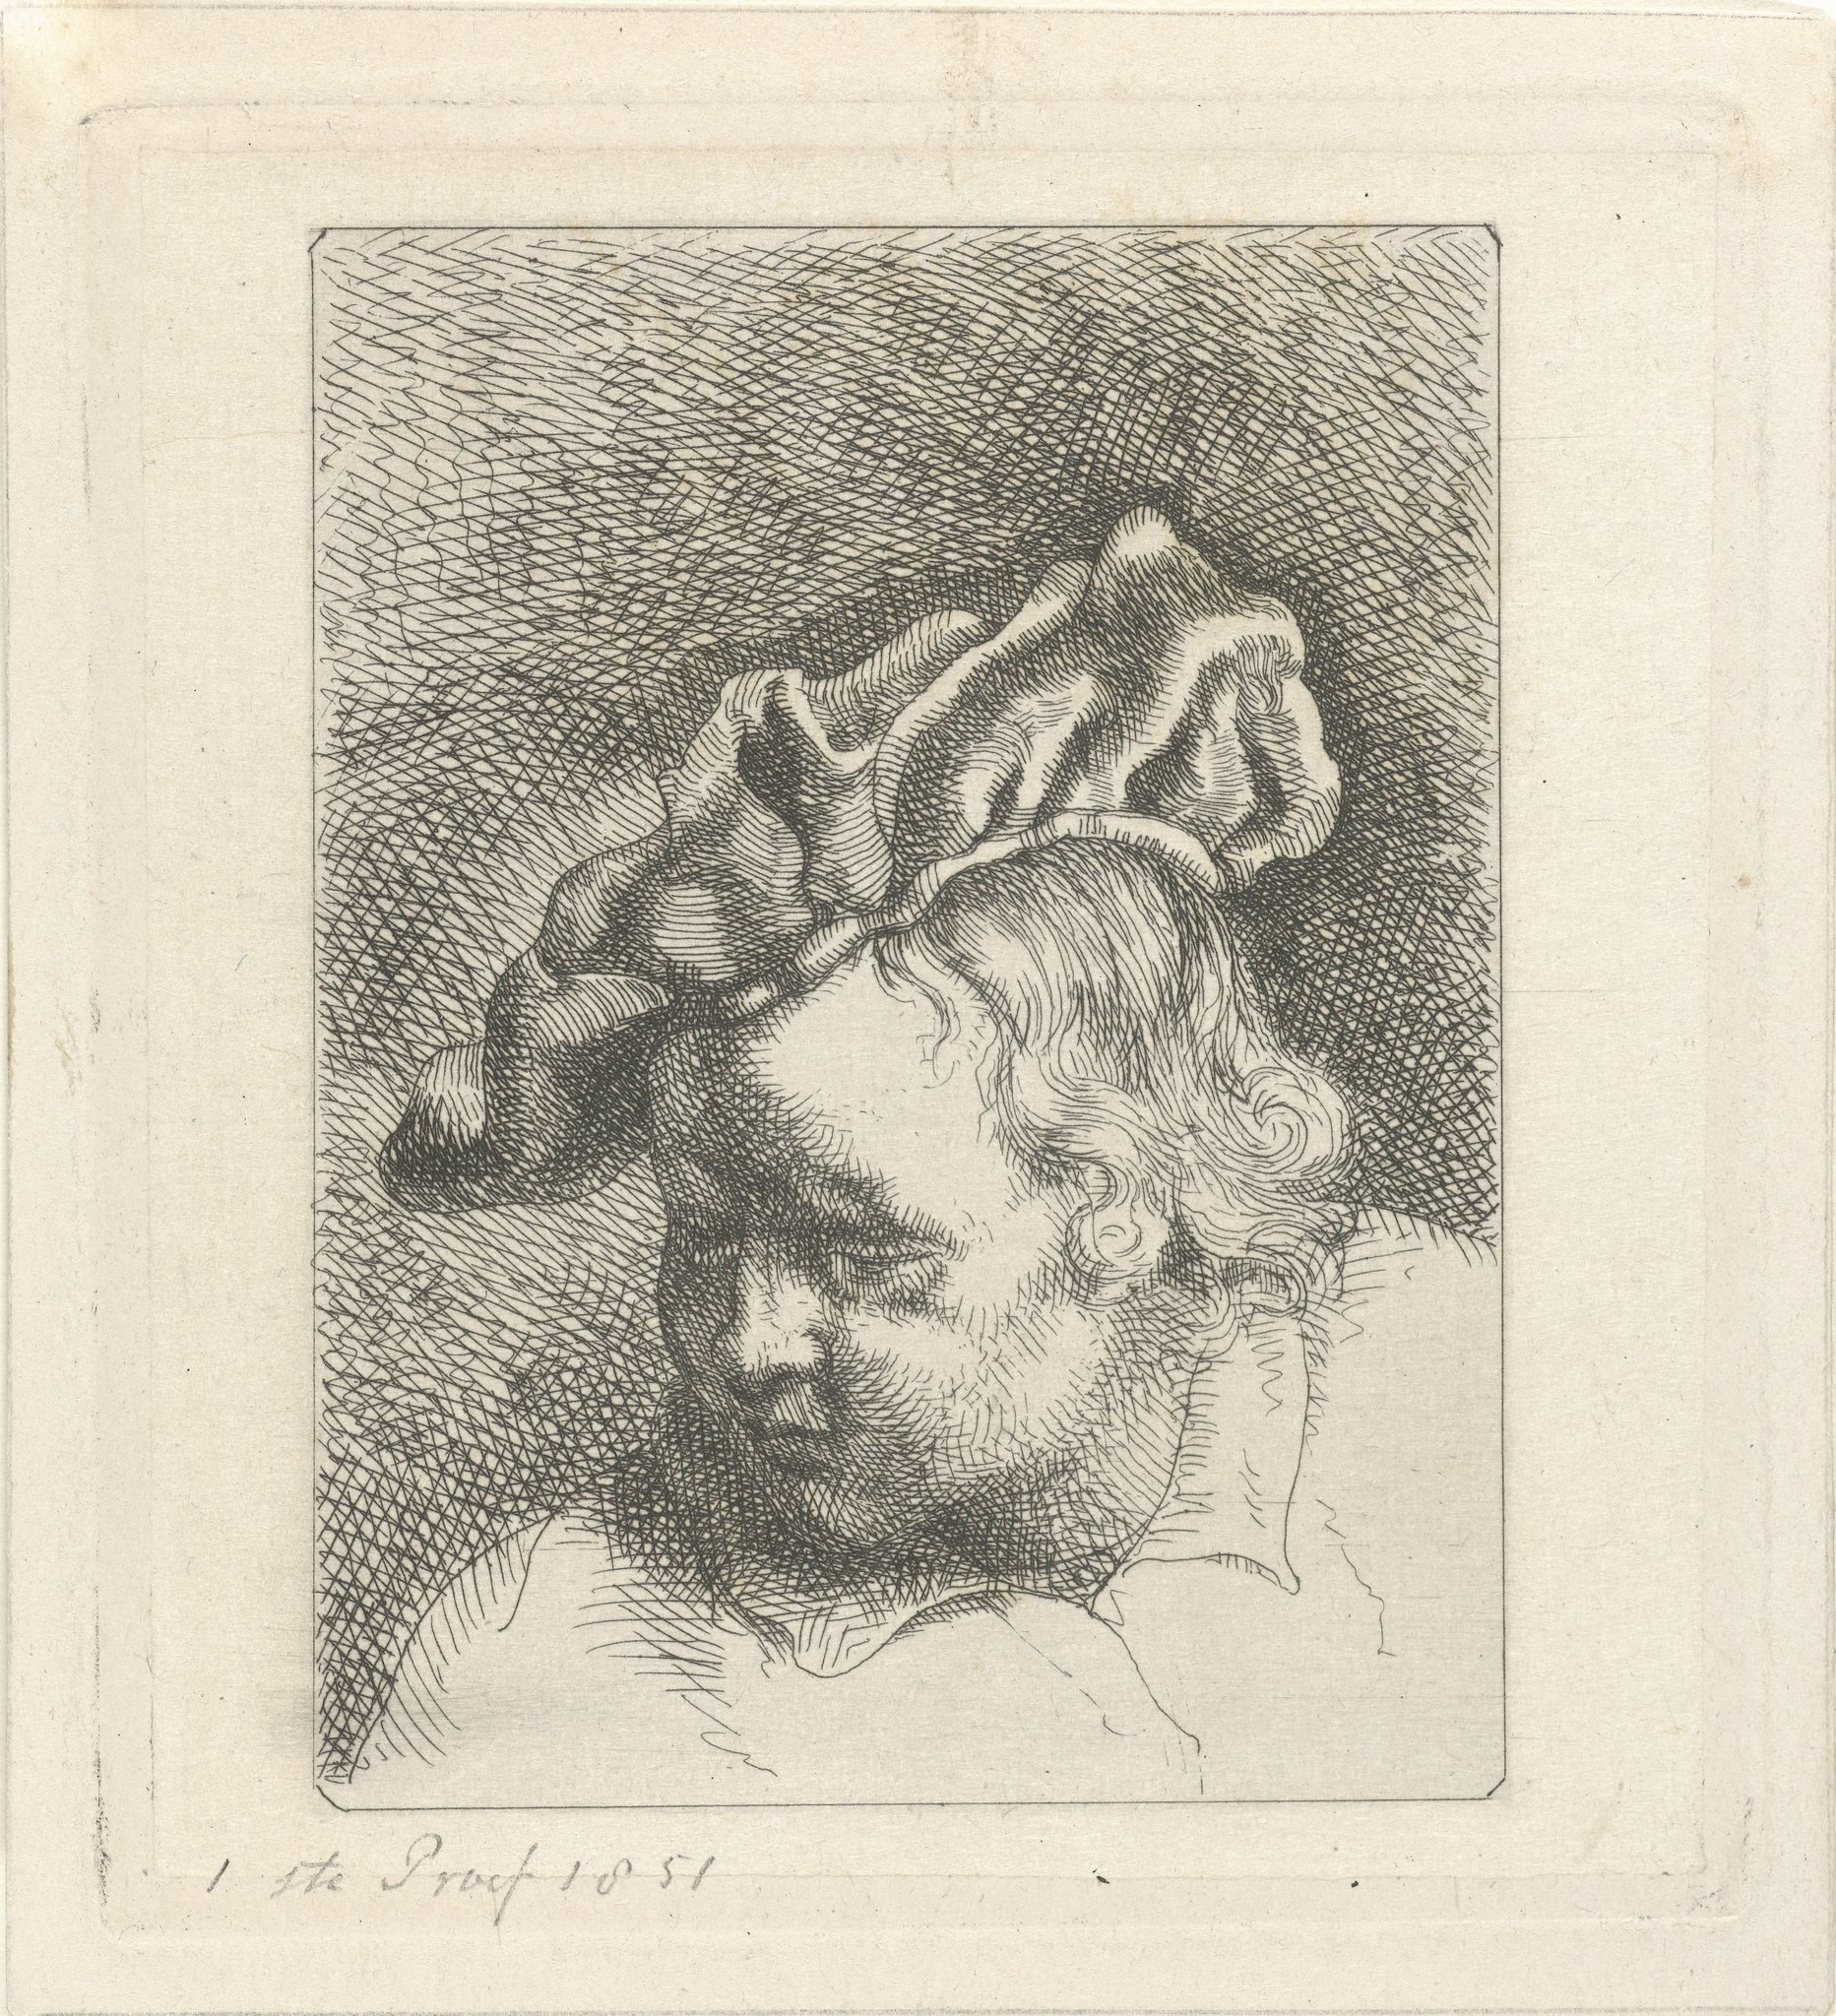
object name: print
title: Jongetje met hoed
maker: jacobus ludovicus cornet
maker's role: draughtsman, print maker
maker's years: 1815-1882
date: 1851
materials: paper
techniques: etching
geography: leiden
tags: head-gear, male infant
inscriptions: collector's mark: Lugt 2228, inscription: ‘1de Proef’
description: Een jongetje met een hoed. Buste naar links.